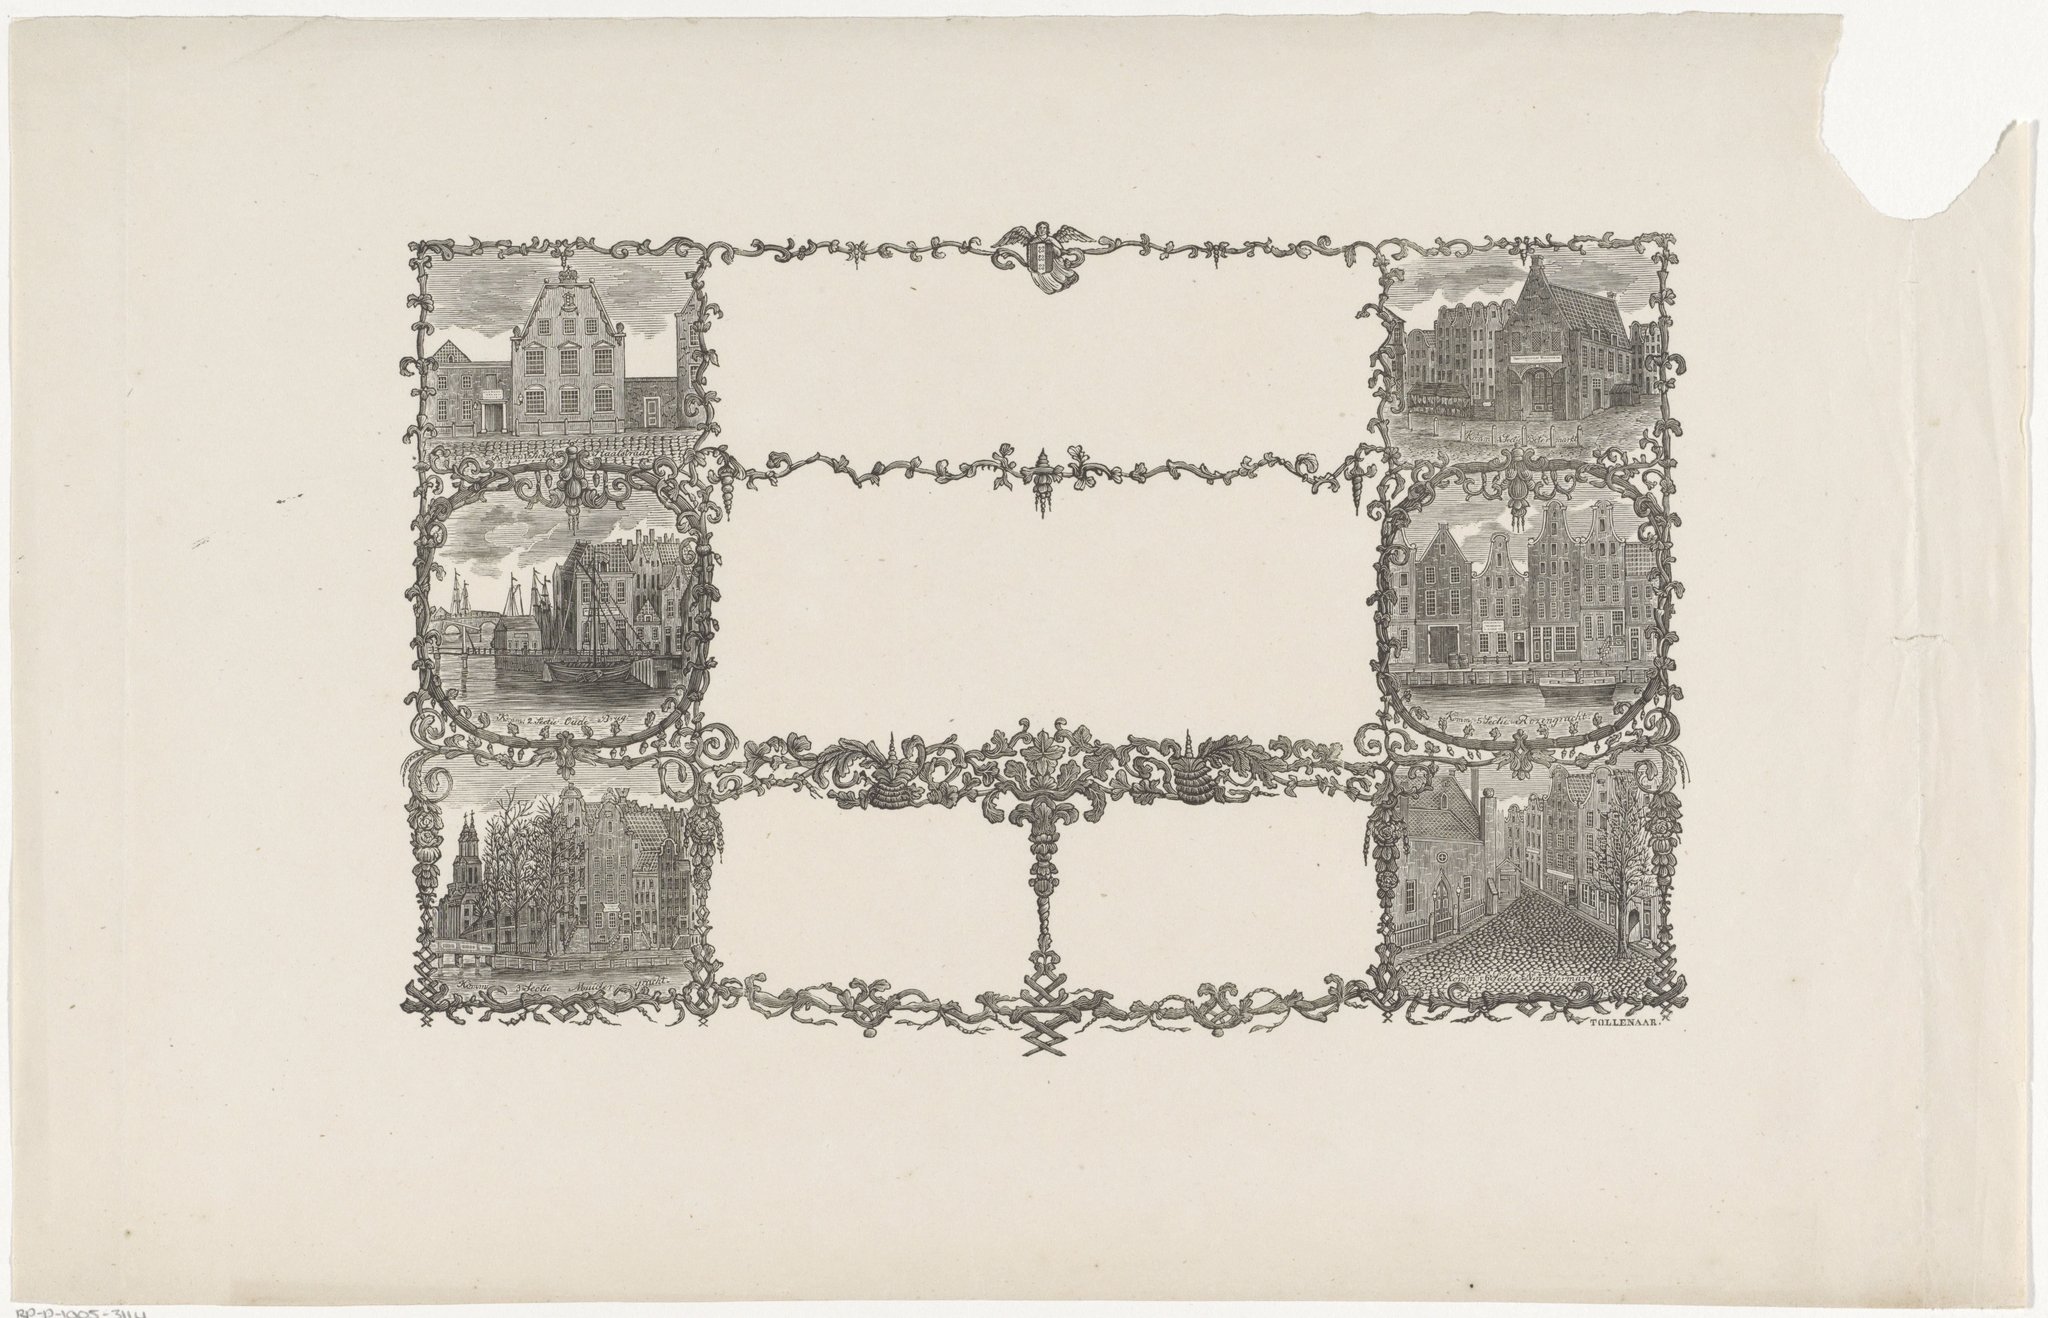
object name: print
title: Geornamenteerde omlijsting met zes stadsgezichten te Amsterdam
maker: antonie vink tollenaar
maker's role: print maker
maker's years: 1805-1875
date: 1815-1875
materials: paper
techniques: engraving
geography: netherlands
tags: square, place, circus, etc., street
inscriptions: collector's mark: Lugt 2228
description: Gezichten op de Staalstraat, de Oude Brug, de Muidergracht, de Botermarkt, de Rozengracht en de Noordermarkt te Amsterdam.